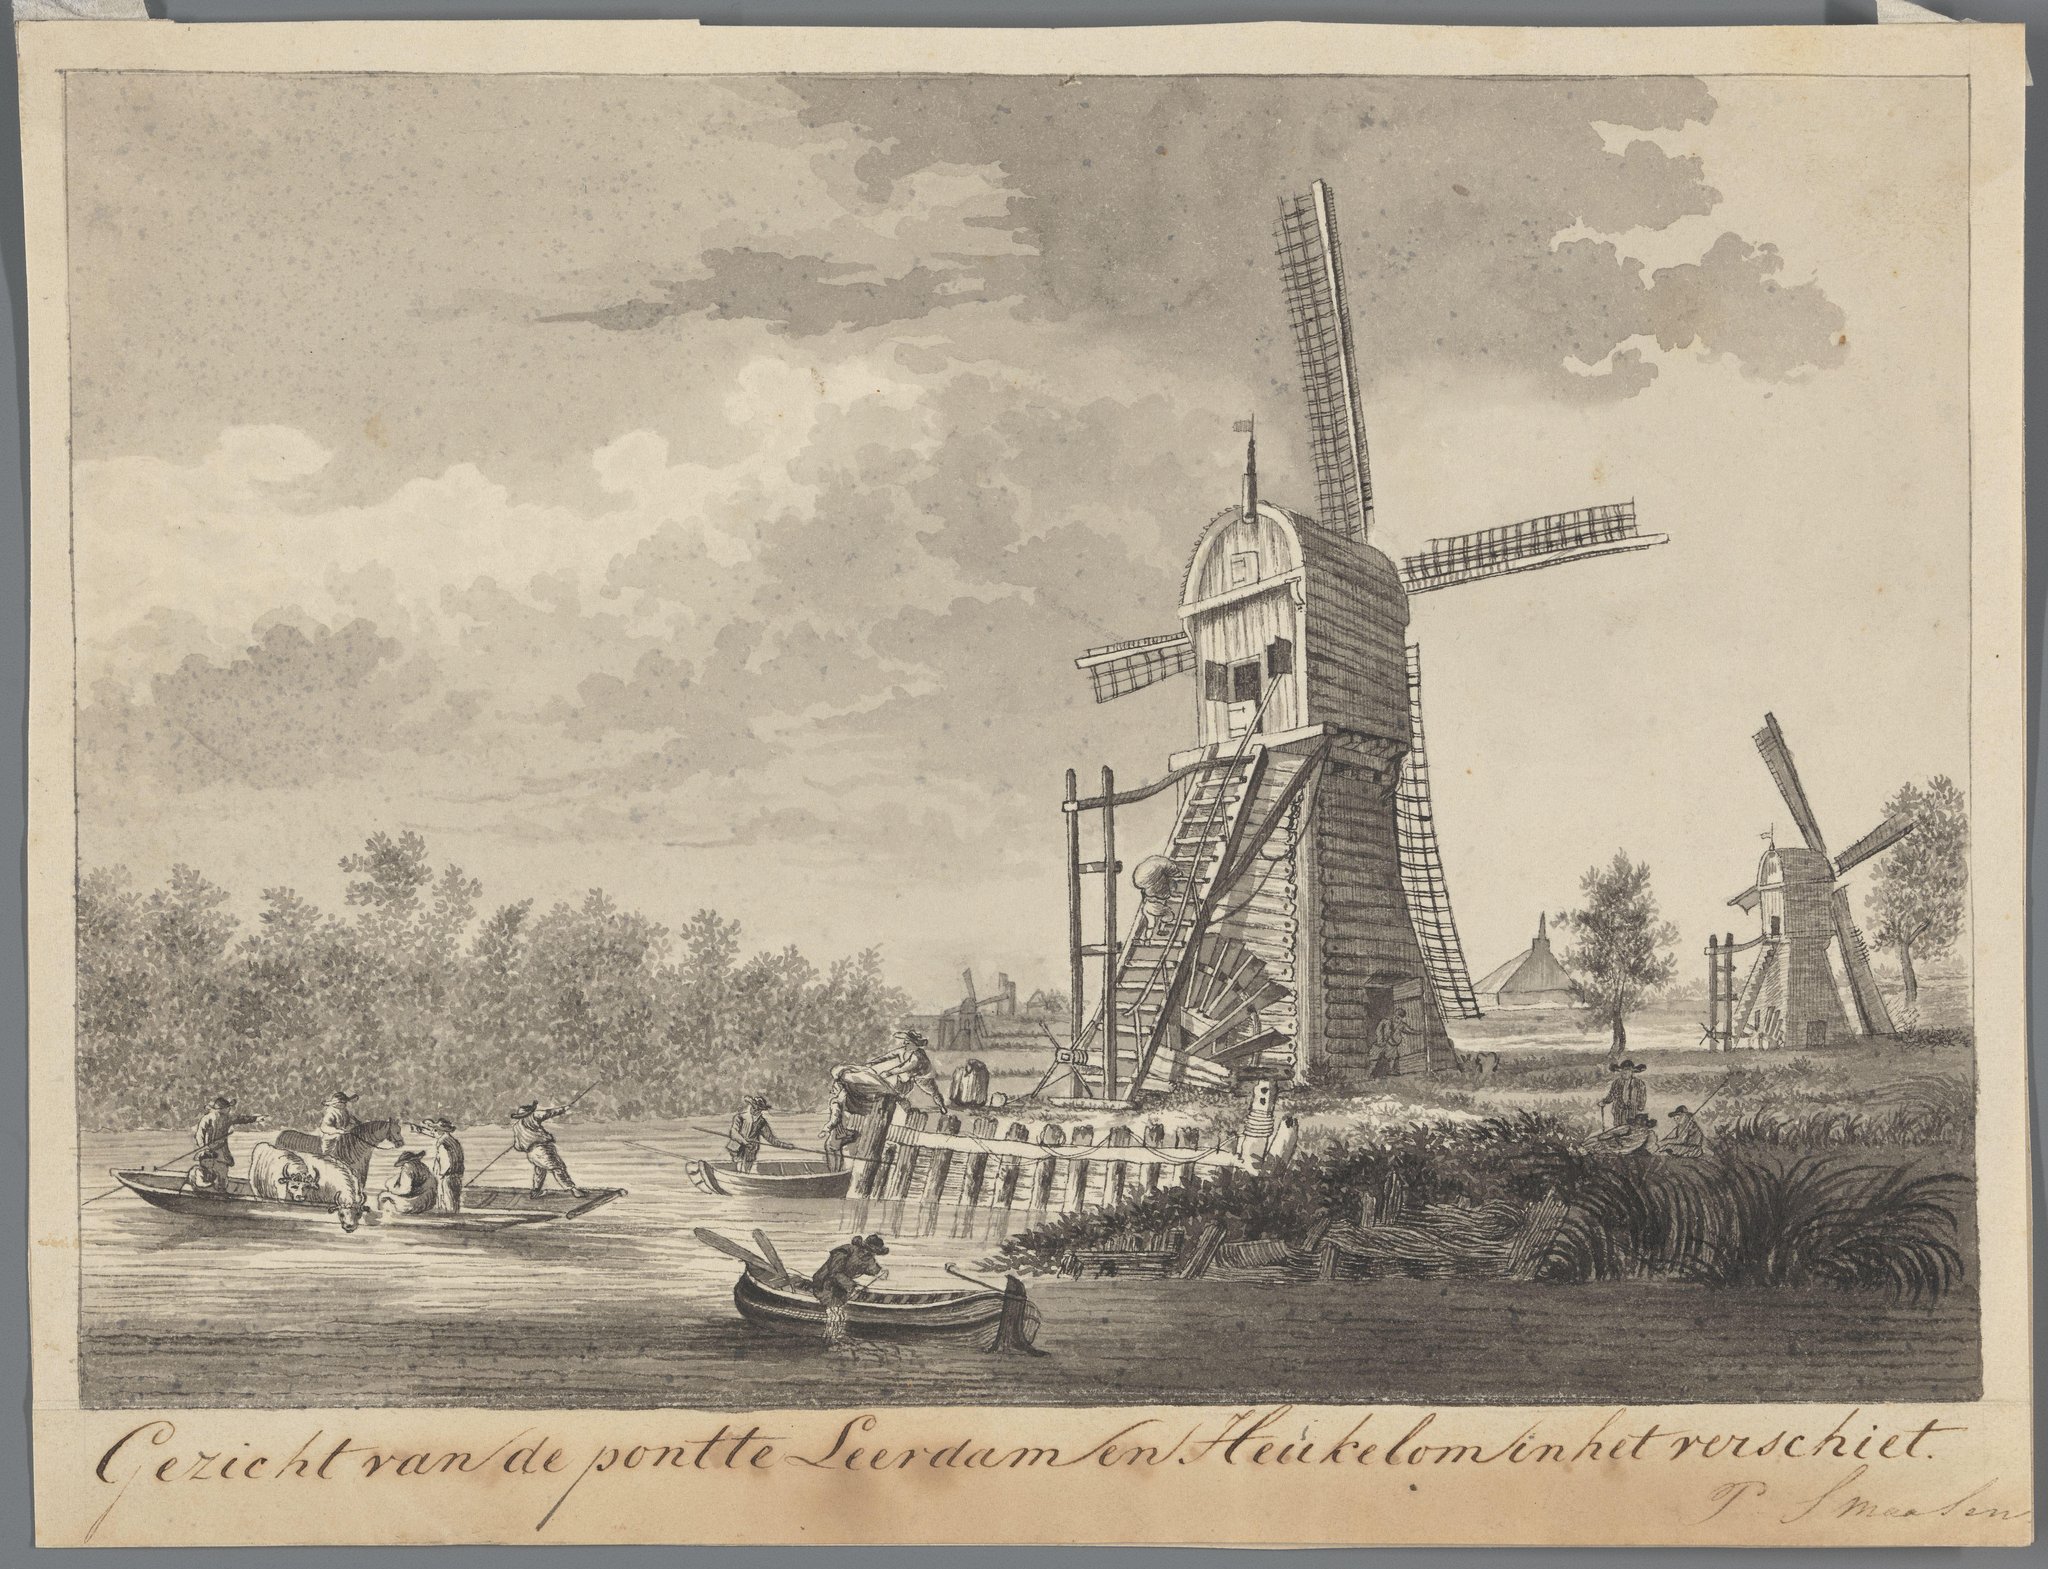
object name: drawing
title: Gezicht van de pont te Leerdam en Heukelom in het verschiet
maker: Anonymous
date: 1801-1850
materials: ink, paper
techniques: brush, pen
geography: netherlands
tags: ferry, river (+ landscape with figures, staffage), windmill in landscape (+ city(-scape) with figures, staffage)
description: Tekening naar een prent van Izaak de Wit, zie RP-P-1905-908.